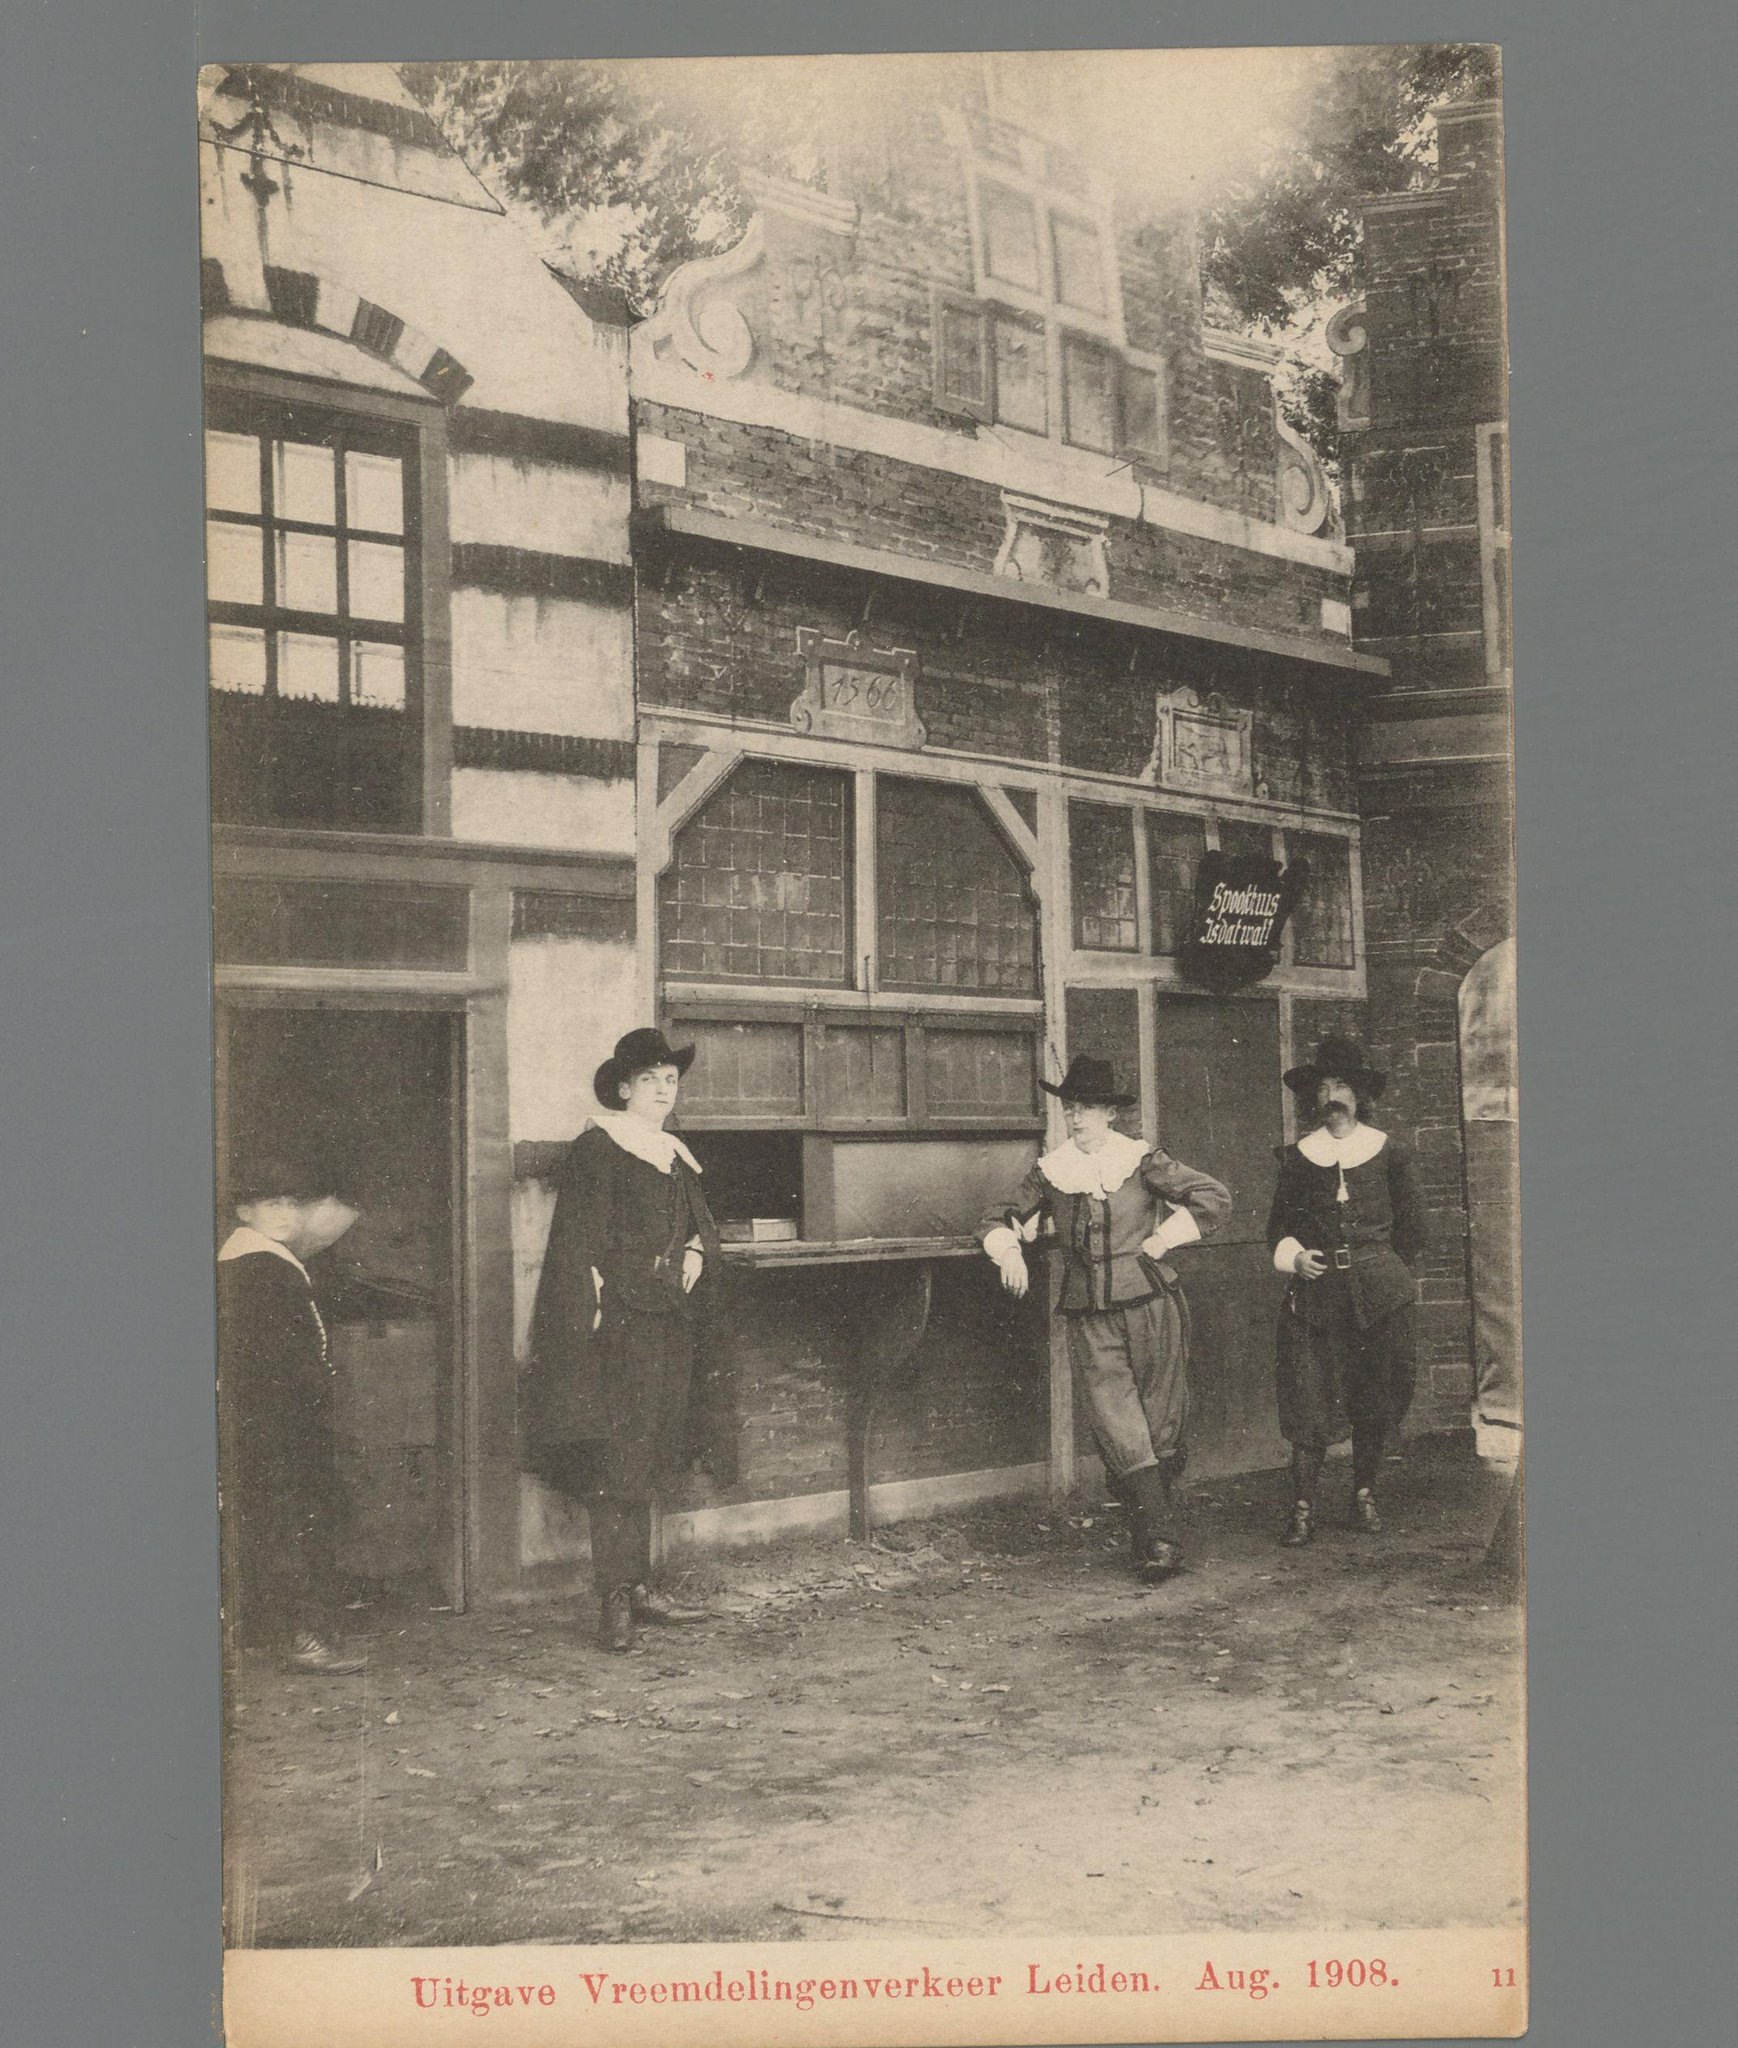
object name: ansichtkaart, prentbriefkaart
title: Mensen in kostuum voor een spookhuis tijdens de Oud-Hollandse feesten te Leiden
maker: Anonymous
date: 1908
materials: cardboard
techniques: photograph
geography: leiden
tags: dress-up party, festivities, leiden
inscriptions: date